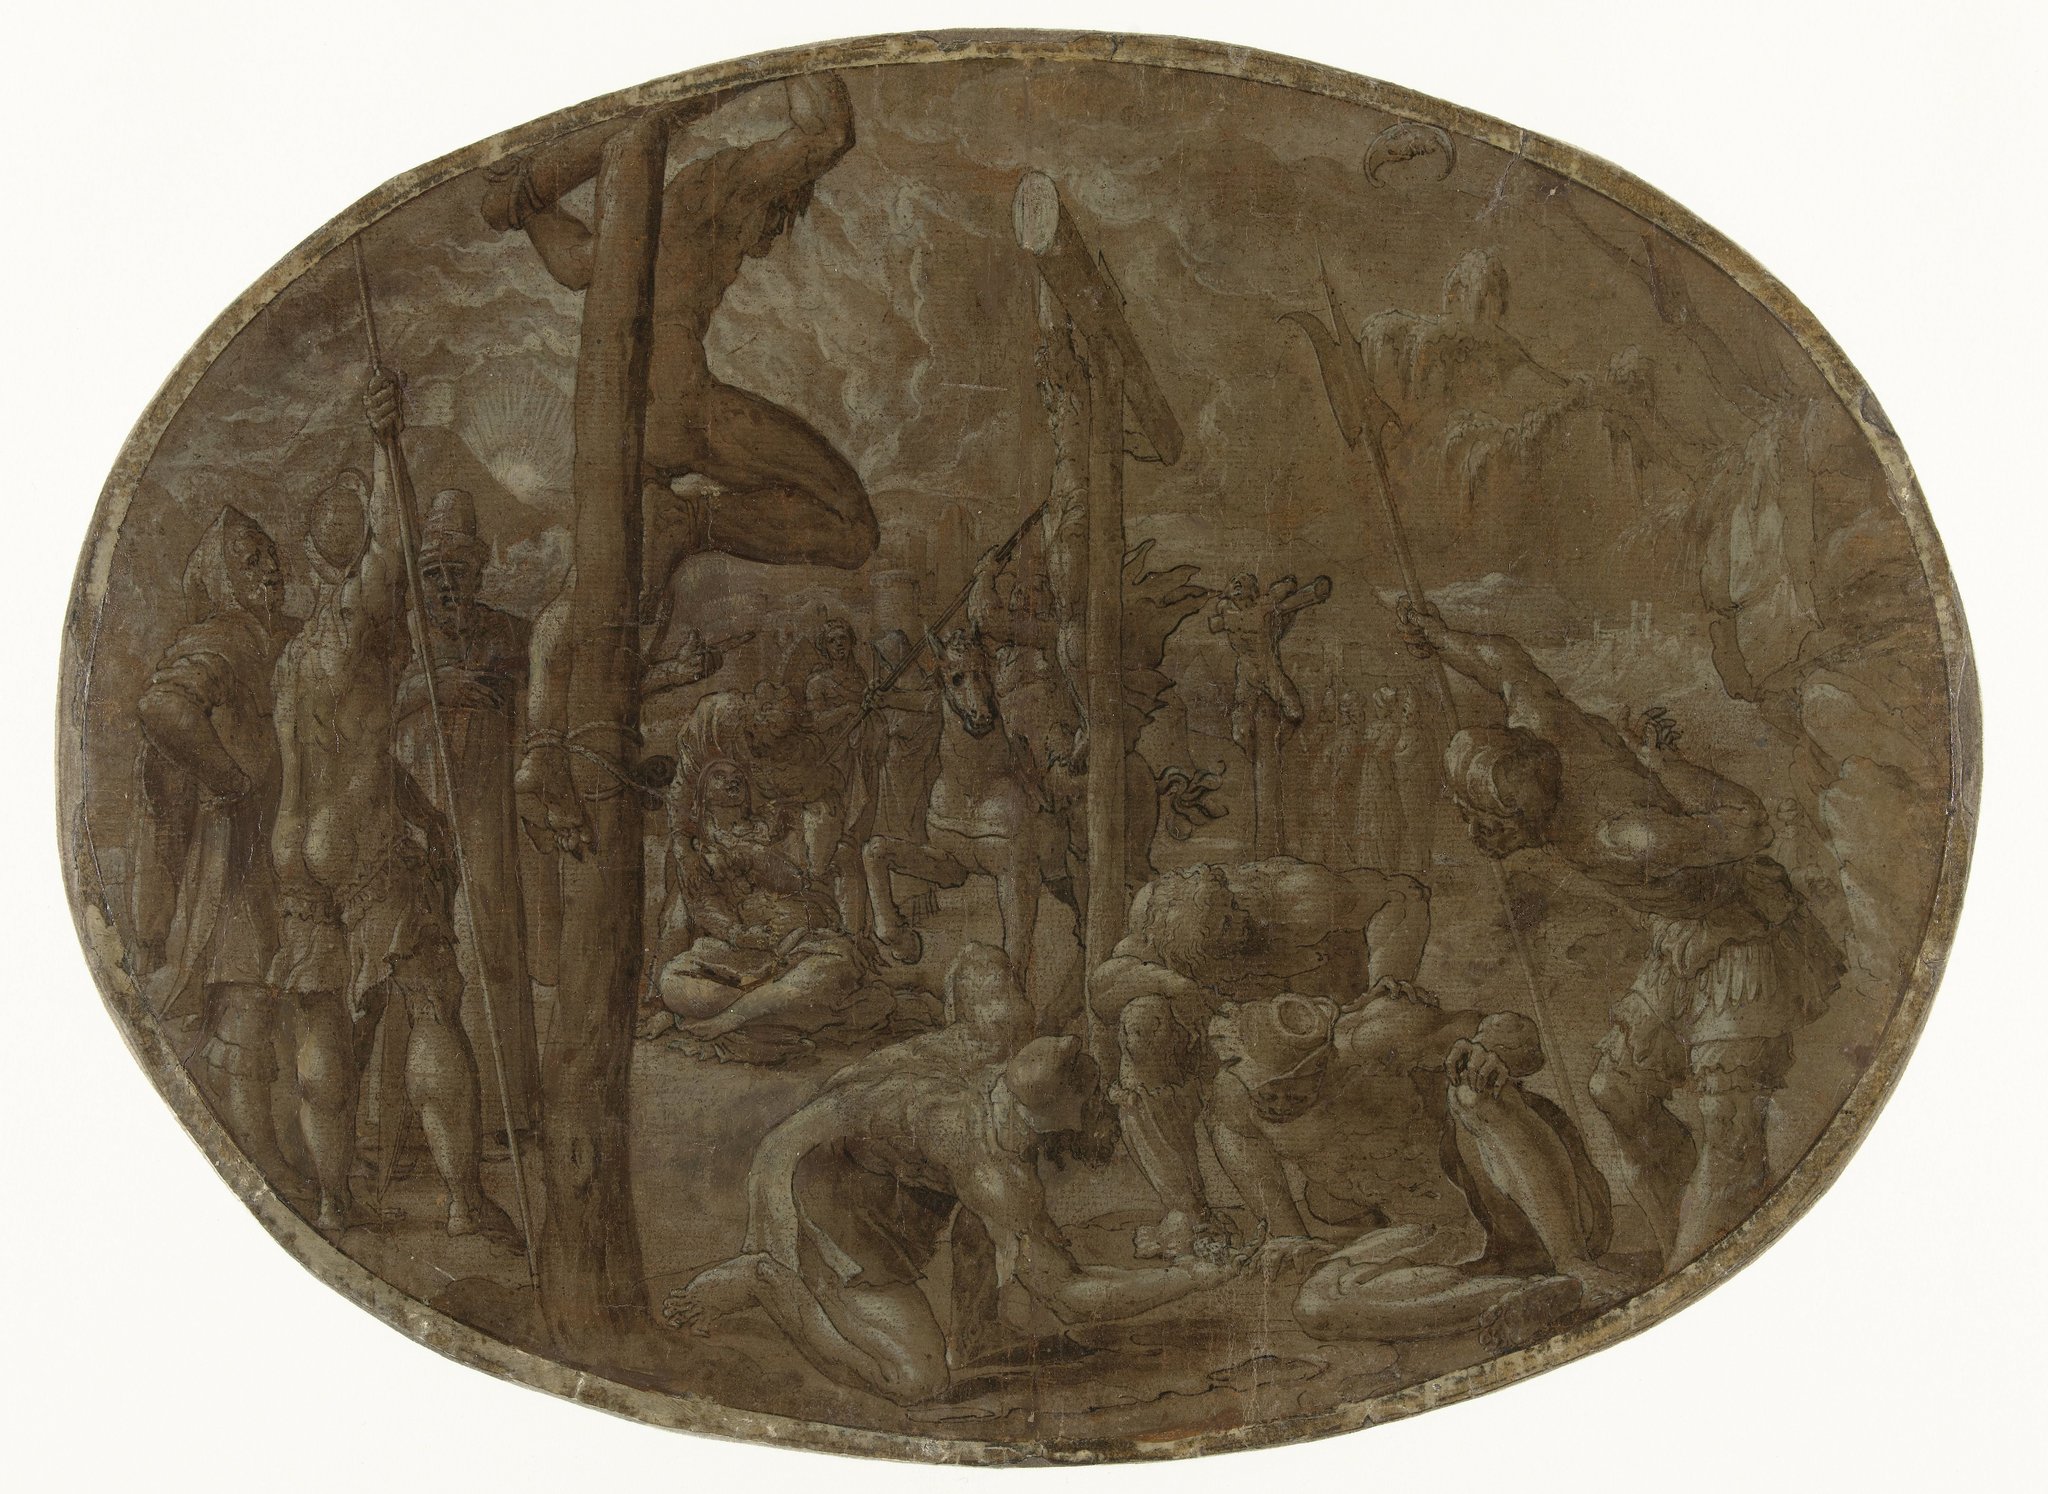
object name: drawing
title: Kruisiging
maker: meester van de liechtensteinse aanbidding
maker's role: draughtsman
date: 1540-1565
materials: ink, paint, paper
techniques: pen, varnishing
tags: the crucifixion of christ: christ's death on the cross; golgotha (matthew 27:45-58; mark 15:33-45; luke 23:44-52; john 19:25-38)